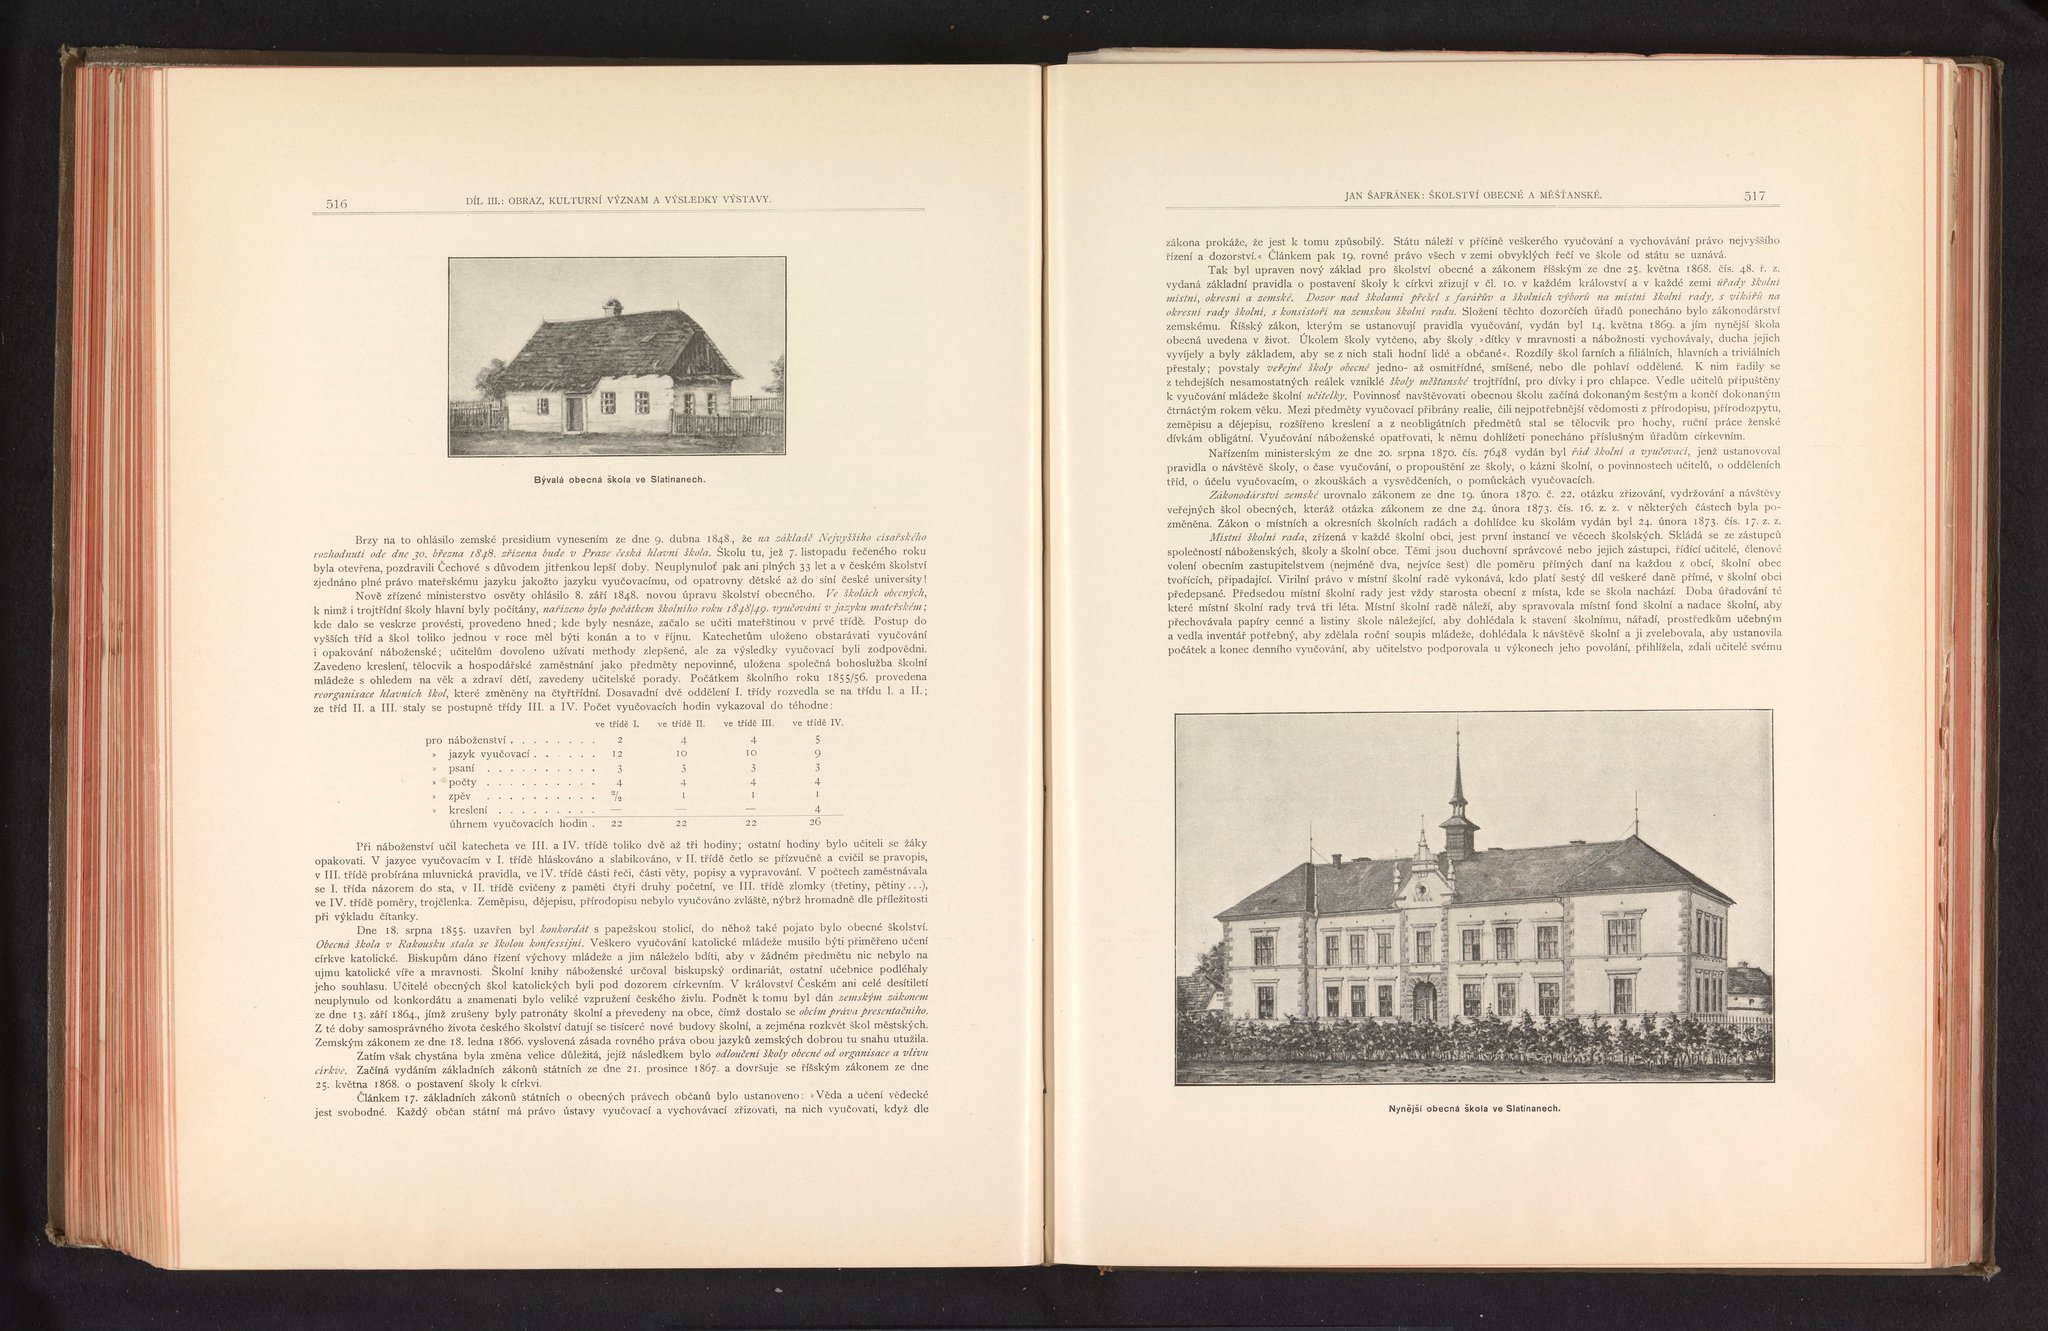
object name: page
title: Nynejsi obecná skola ve Slatinanech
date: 1891-1895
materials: paper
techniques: autotype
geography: prague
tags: façade (of house or building), elementary school; class, form